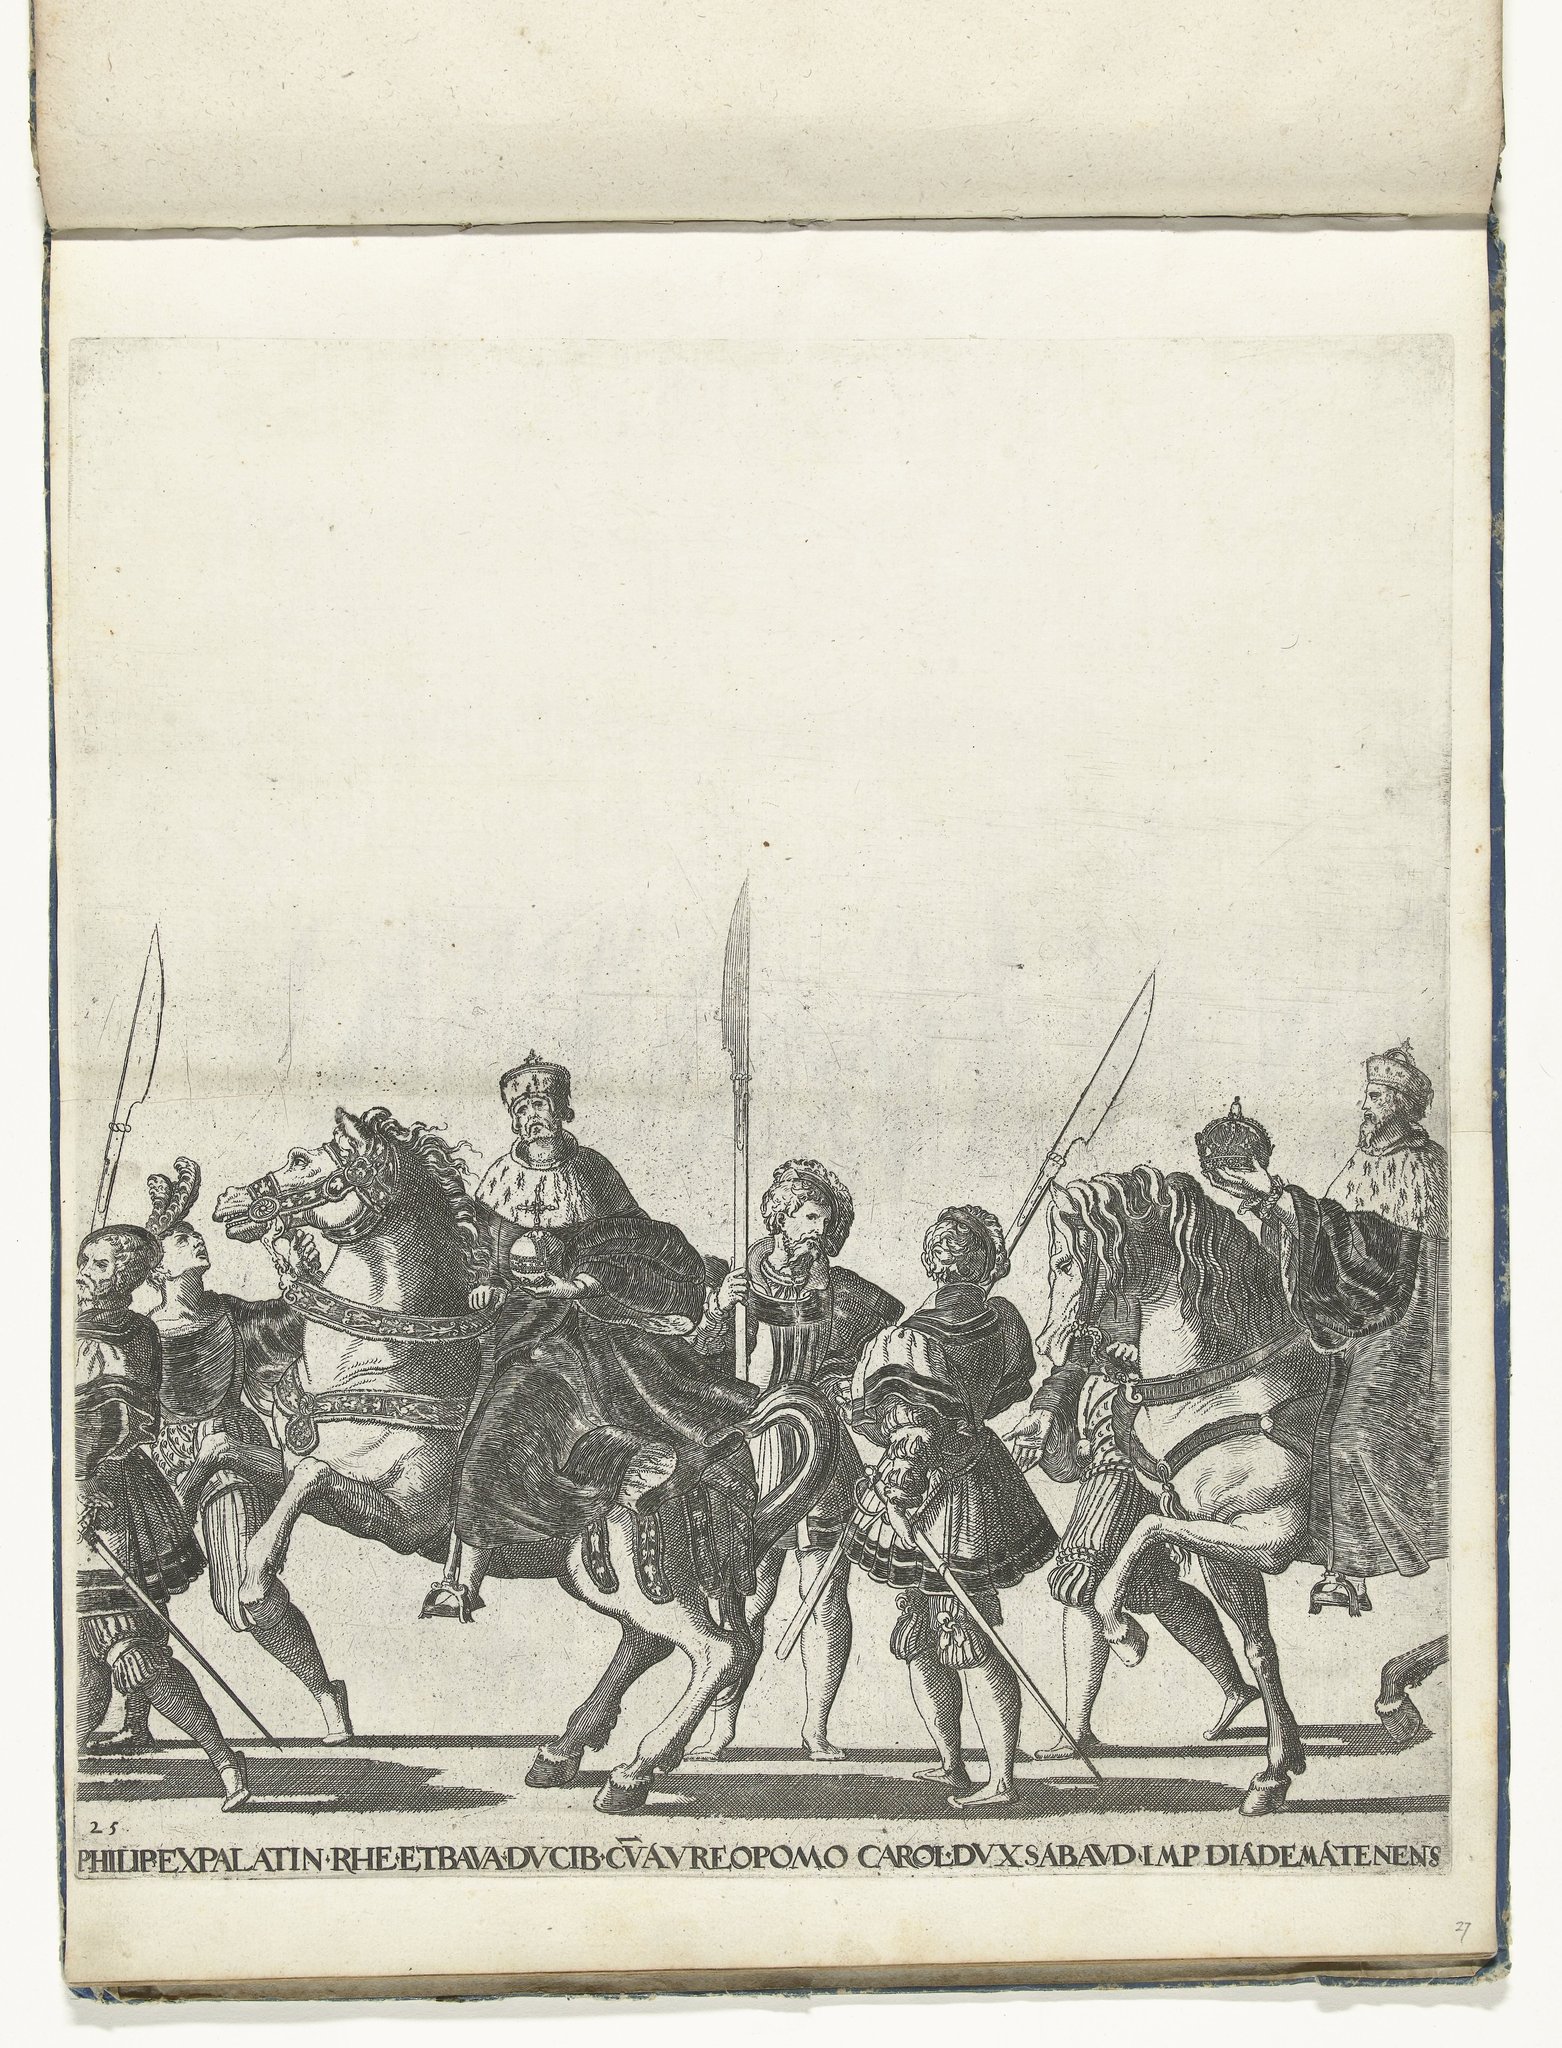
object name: album leaf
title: Filips, paltsgraaf en hertog van Beieren, met de rijksappel en Karel III, hertog van Savoye, met de keizerskroon, plaat 25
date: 1530-1536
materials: paper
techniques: engraving, etching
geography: mechelen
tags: charles v (holy roman emperor and king of spain), festivities (+ parade, pageant, cavalcade ~ festive activities)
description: Filips, paltsgraaf en hertog van Beieren, met de rijksappel en Karel III, hertog van Savoye, met de keizerskroon, plaat 25. Optocht van Karel V met de paus Clemens VII te Bologna na zijn kroning to keizer, 24 februari 1530.